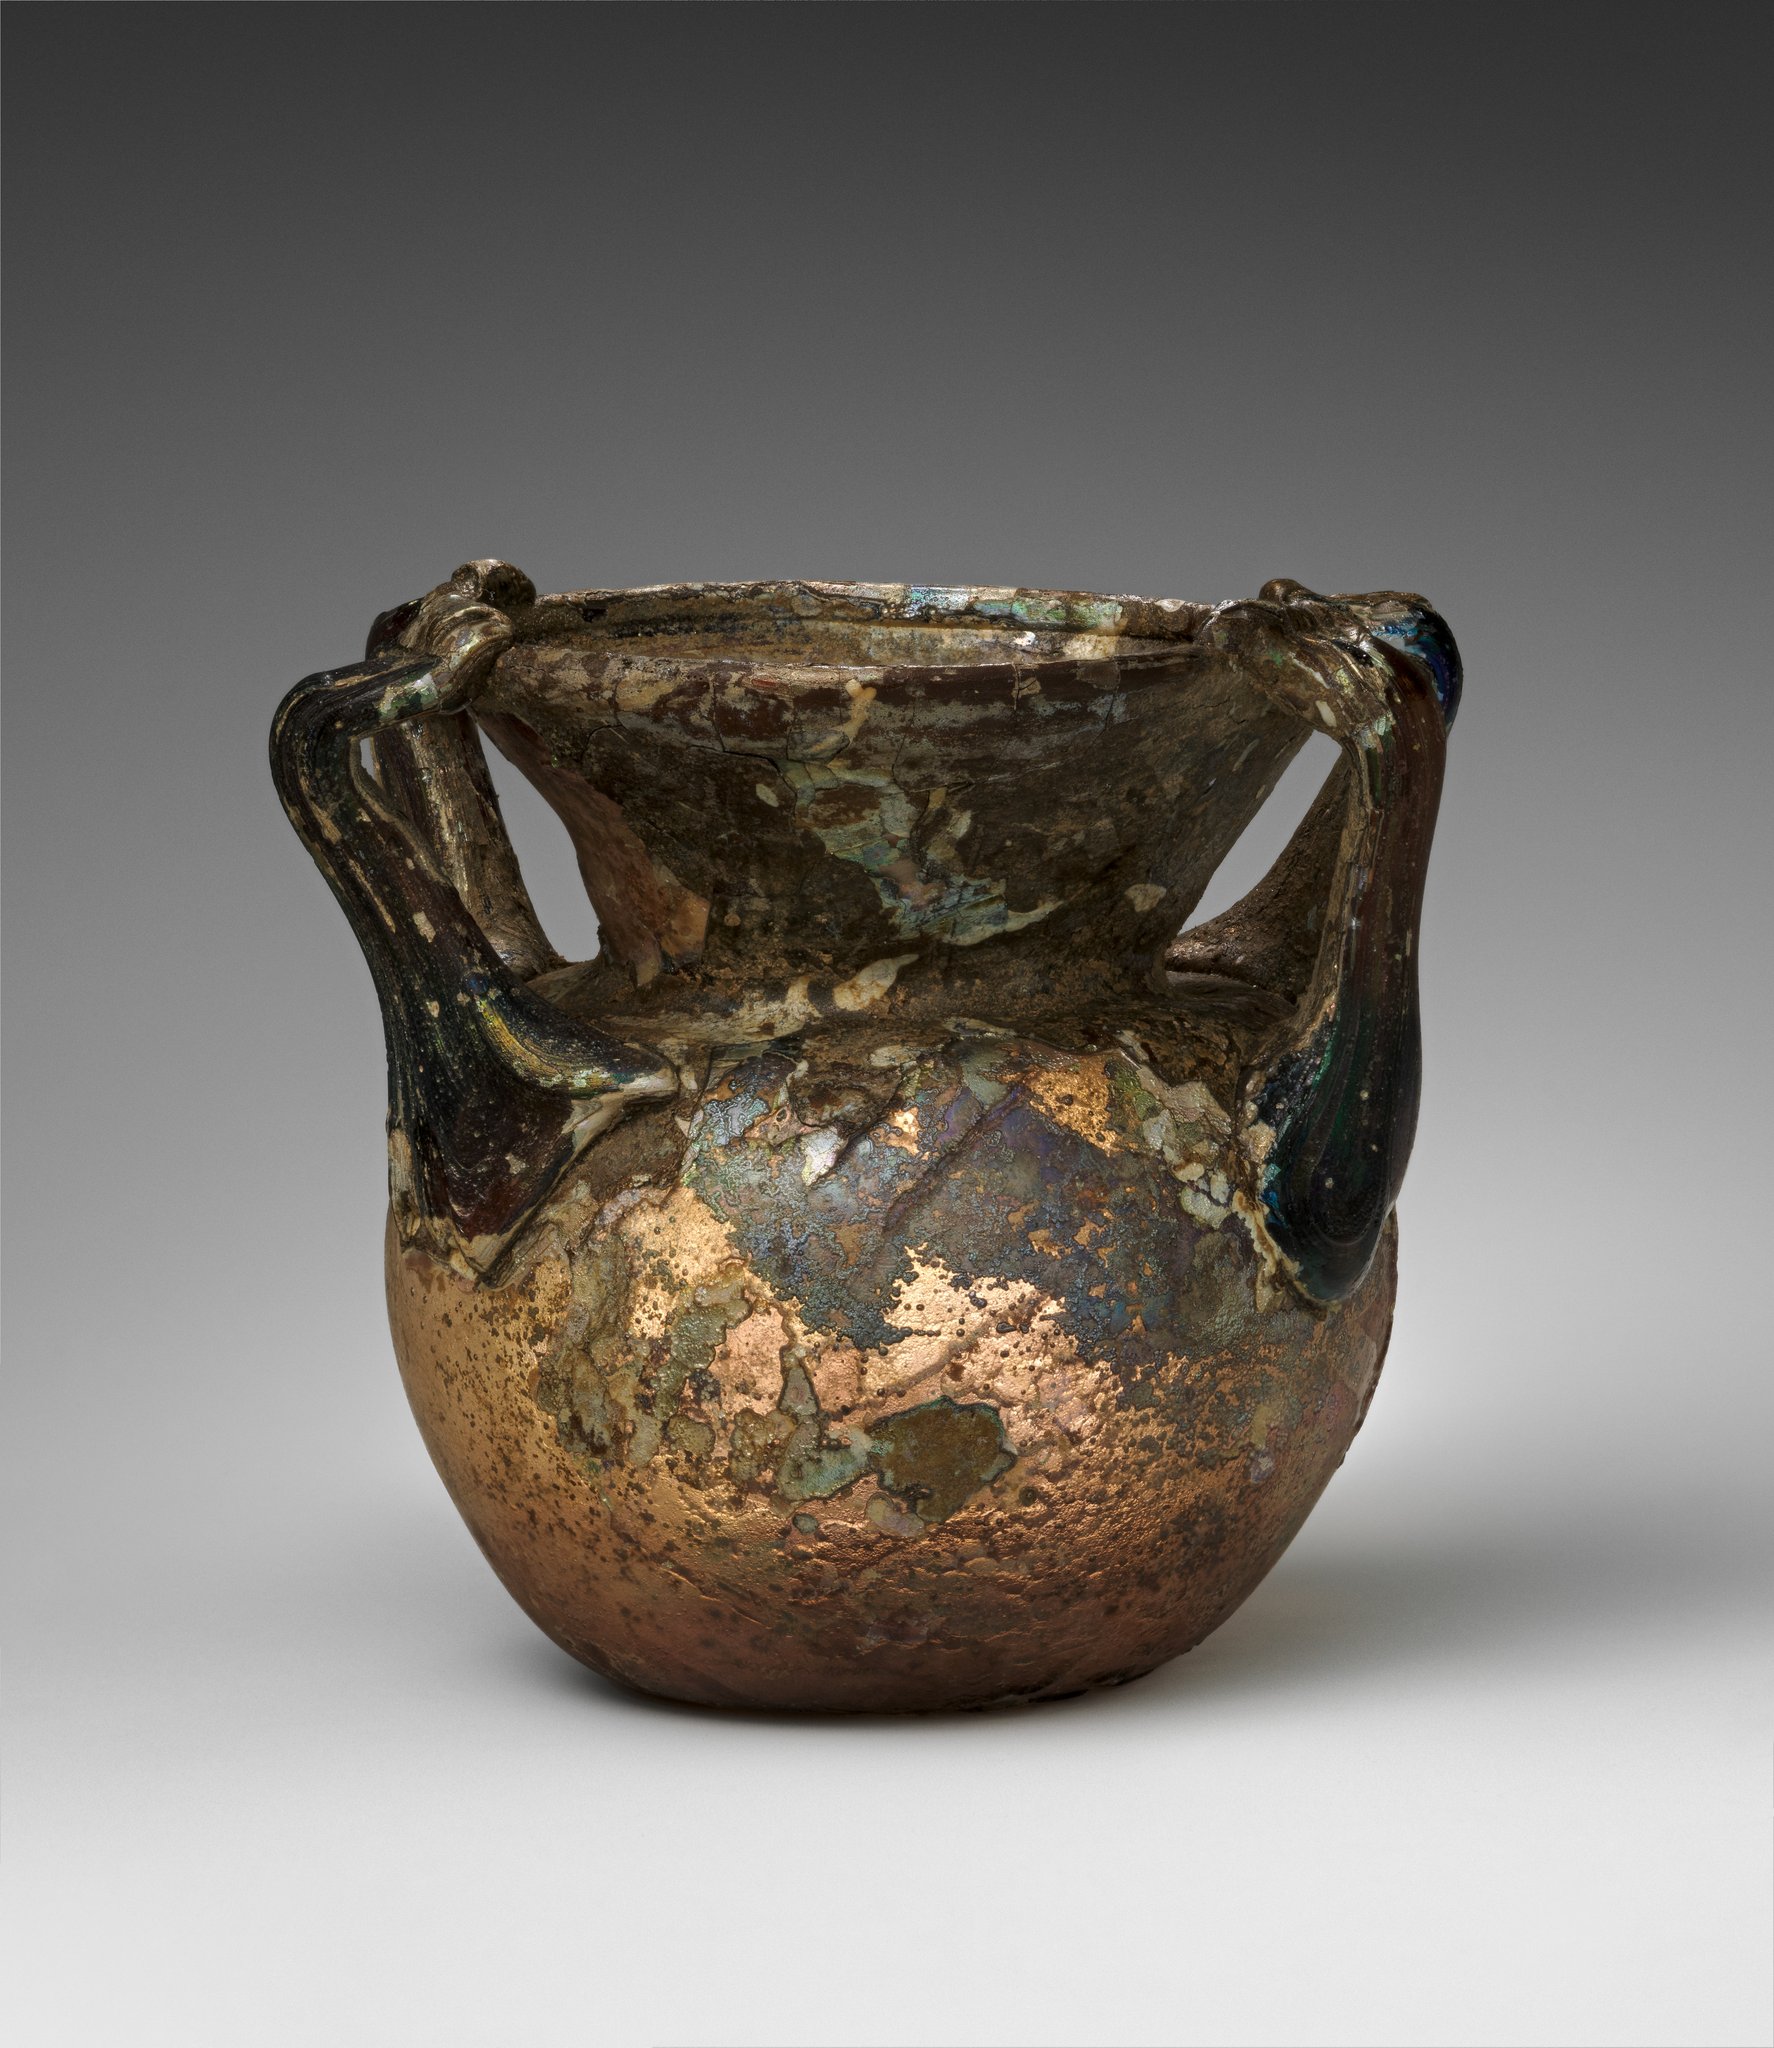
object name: jar, handled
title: Glass jar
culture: roman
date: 301-400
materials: glass